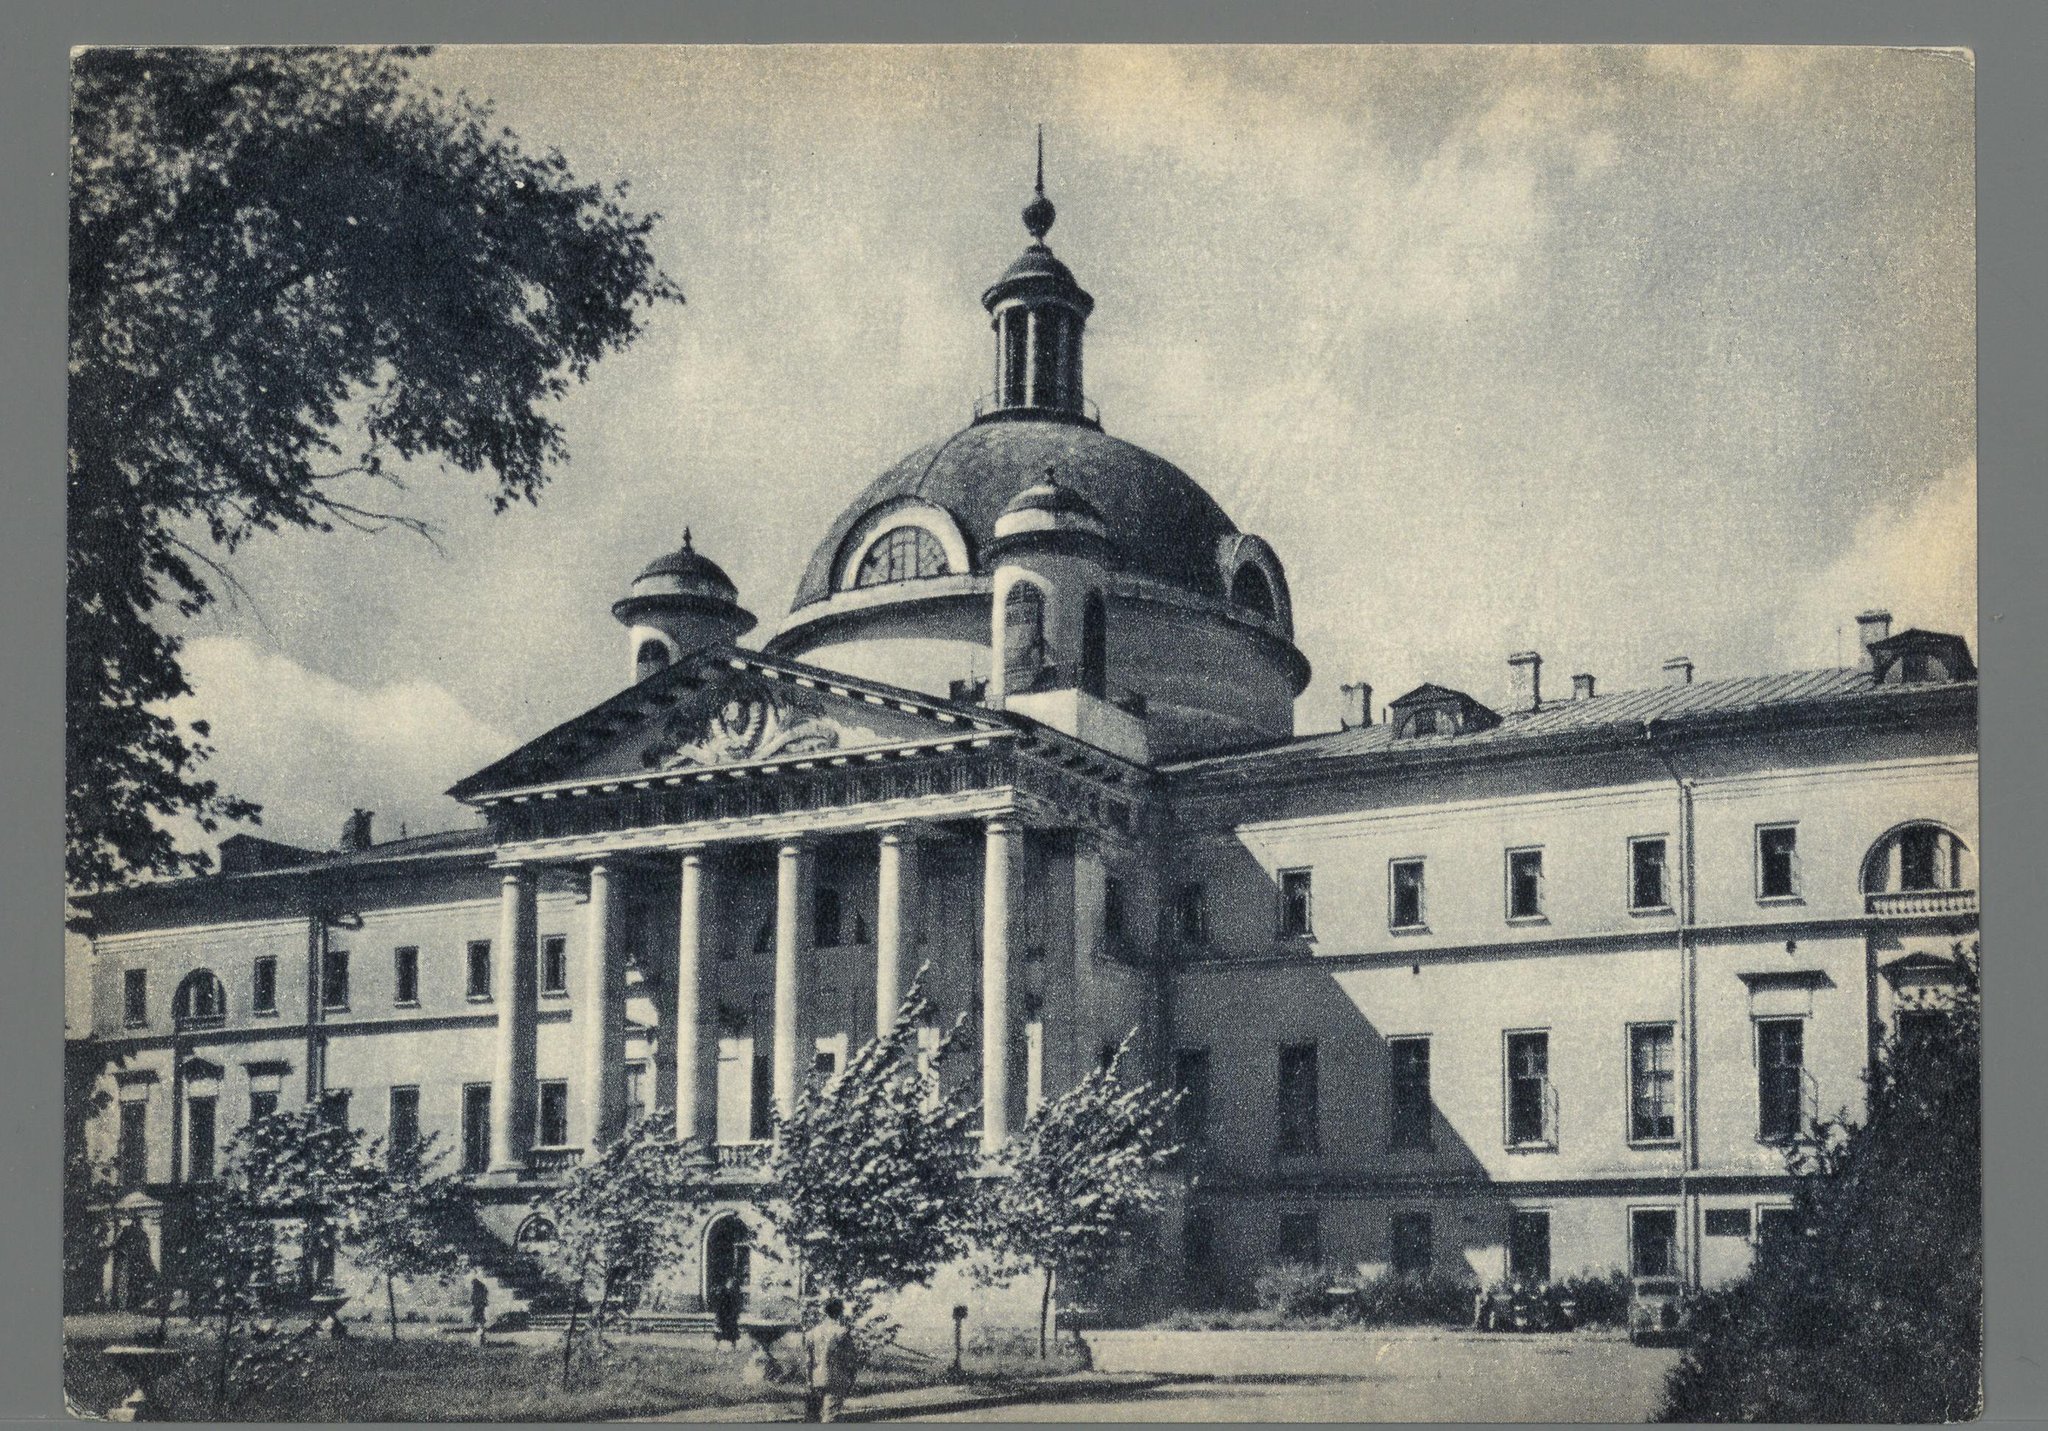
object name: ansichtkaart, prentbriefkaart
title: Gezicht op het Golitsyn ziekenhuis te Moskou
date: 1957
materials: cardboard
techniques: rotogravure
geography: moscow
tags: hospital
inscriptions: date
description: De titel op object staat in het Russisch.